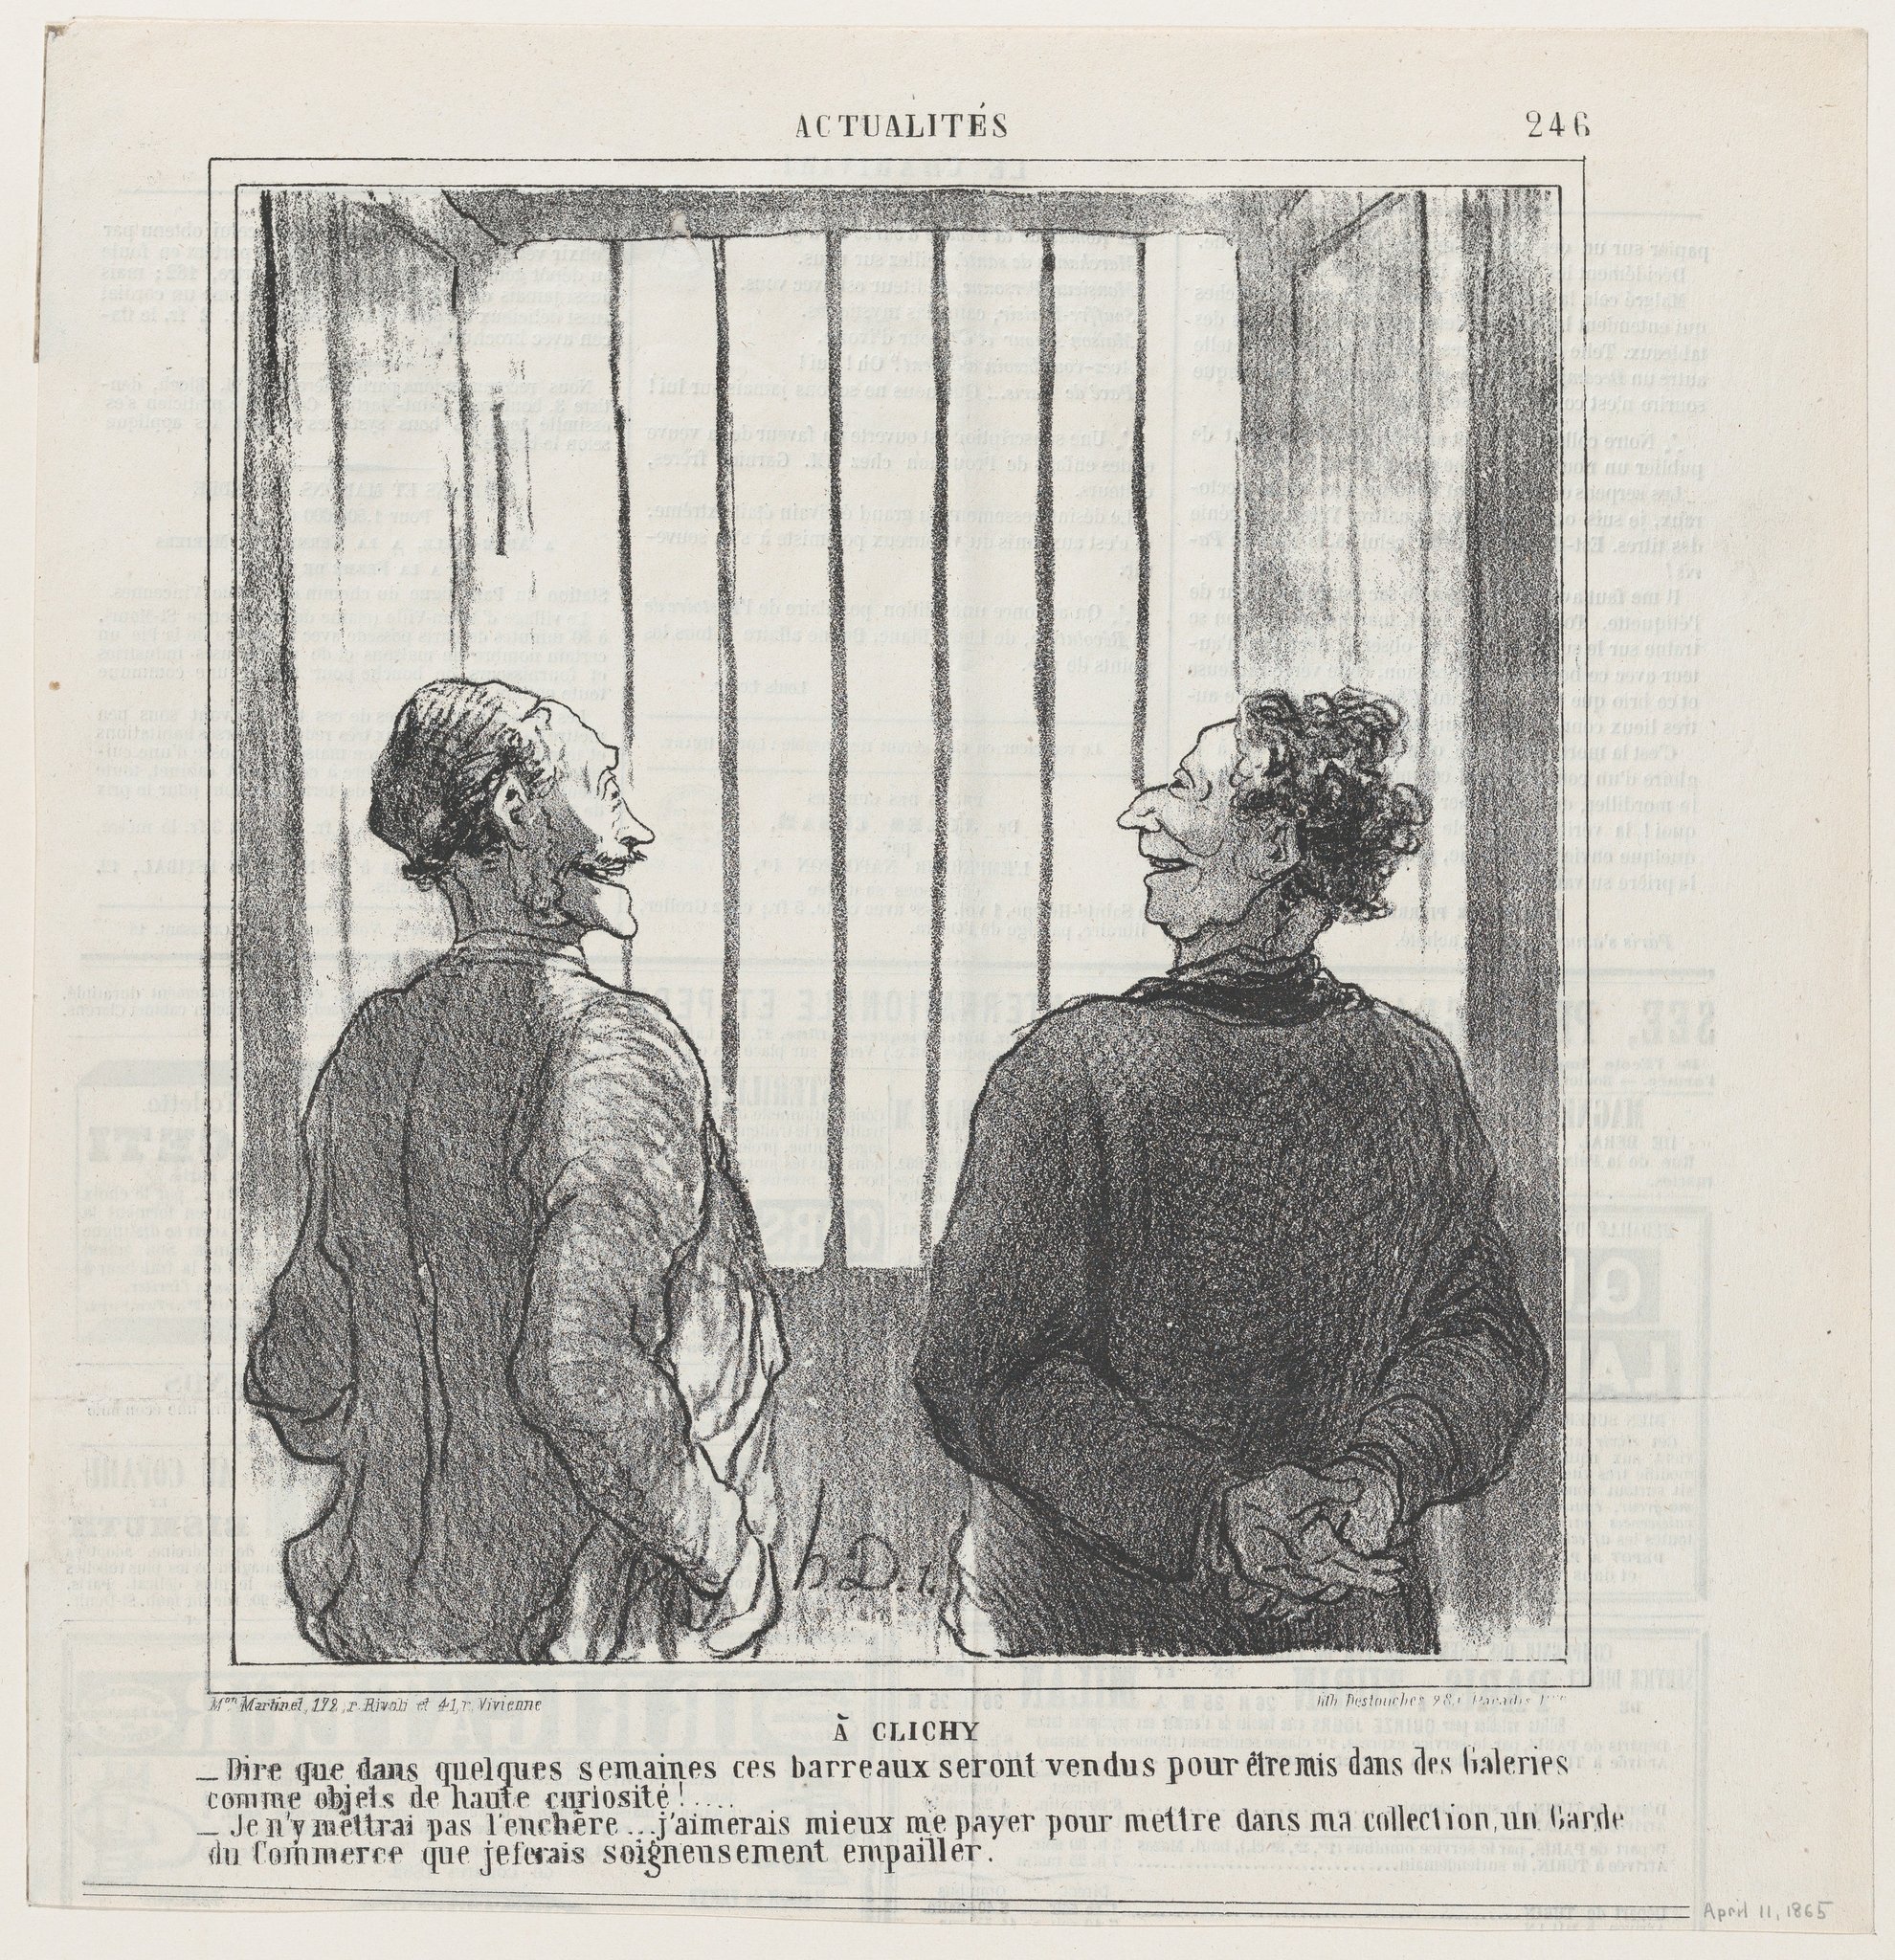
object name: print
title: In Clichy, from 'News of the day,' published in Le Charivari, April 11, 1865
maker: honoré daumier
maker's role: artist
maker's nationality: french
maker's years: 1808-1879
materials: paper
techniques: lithograph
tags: satire,men